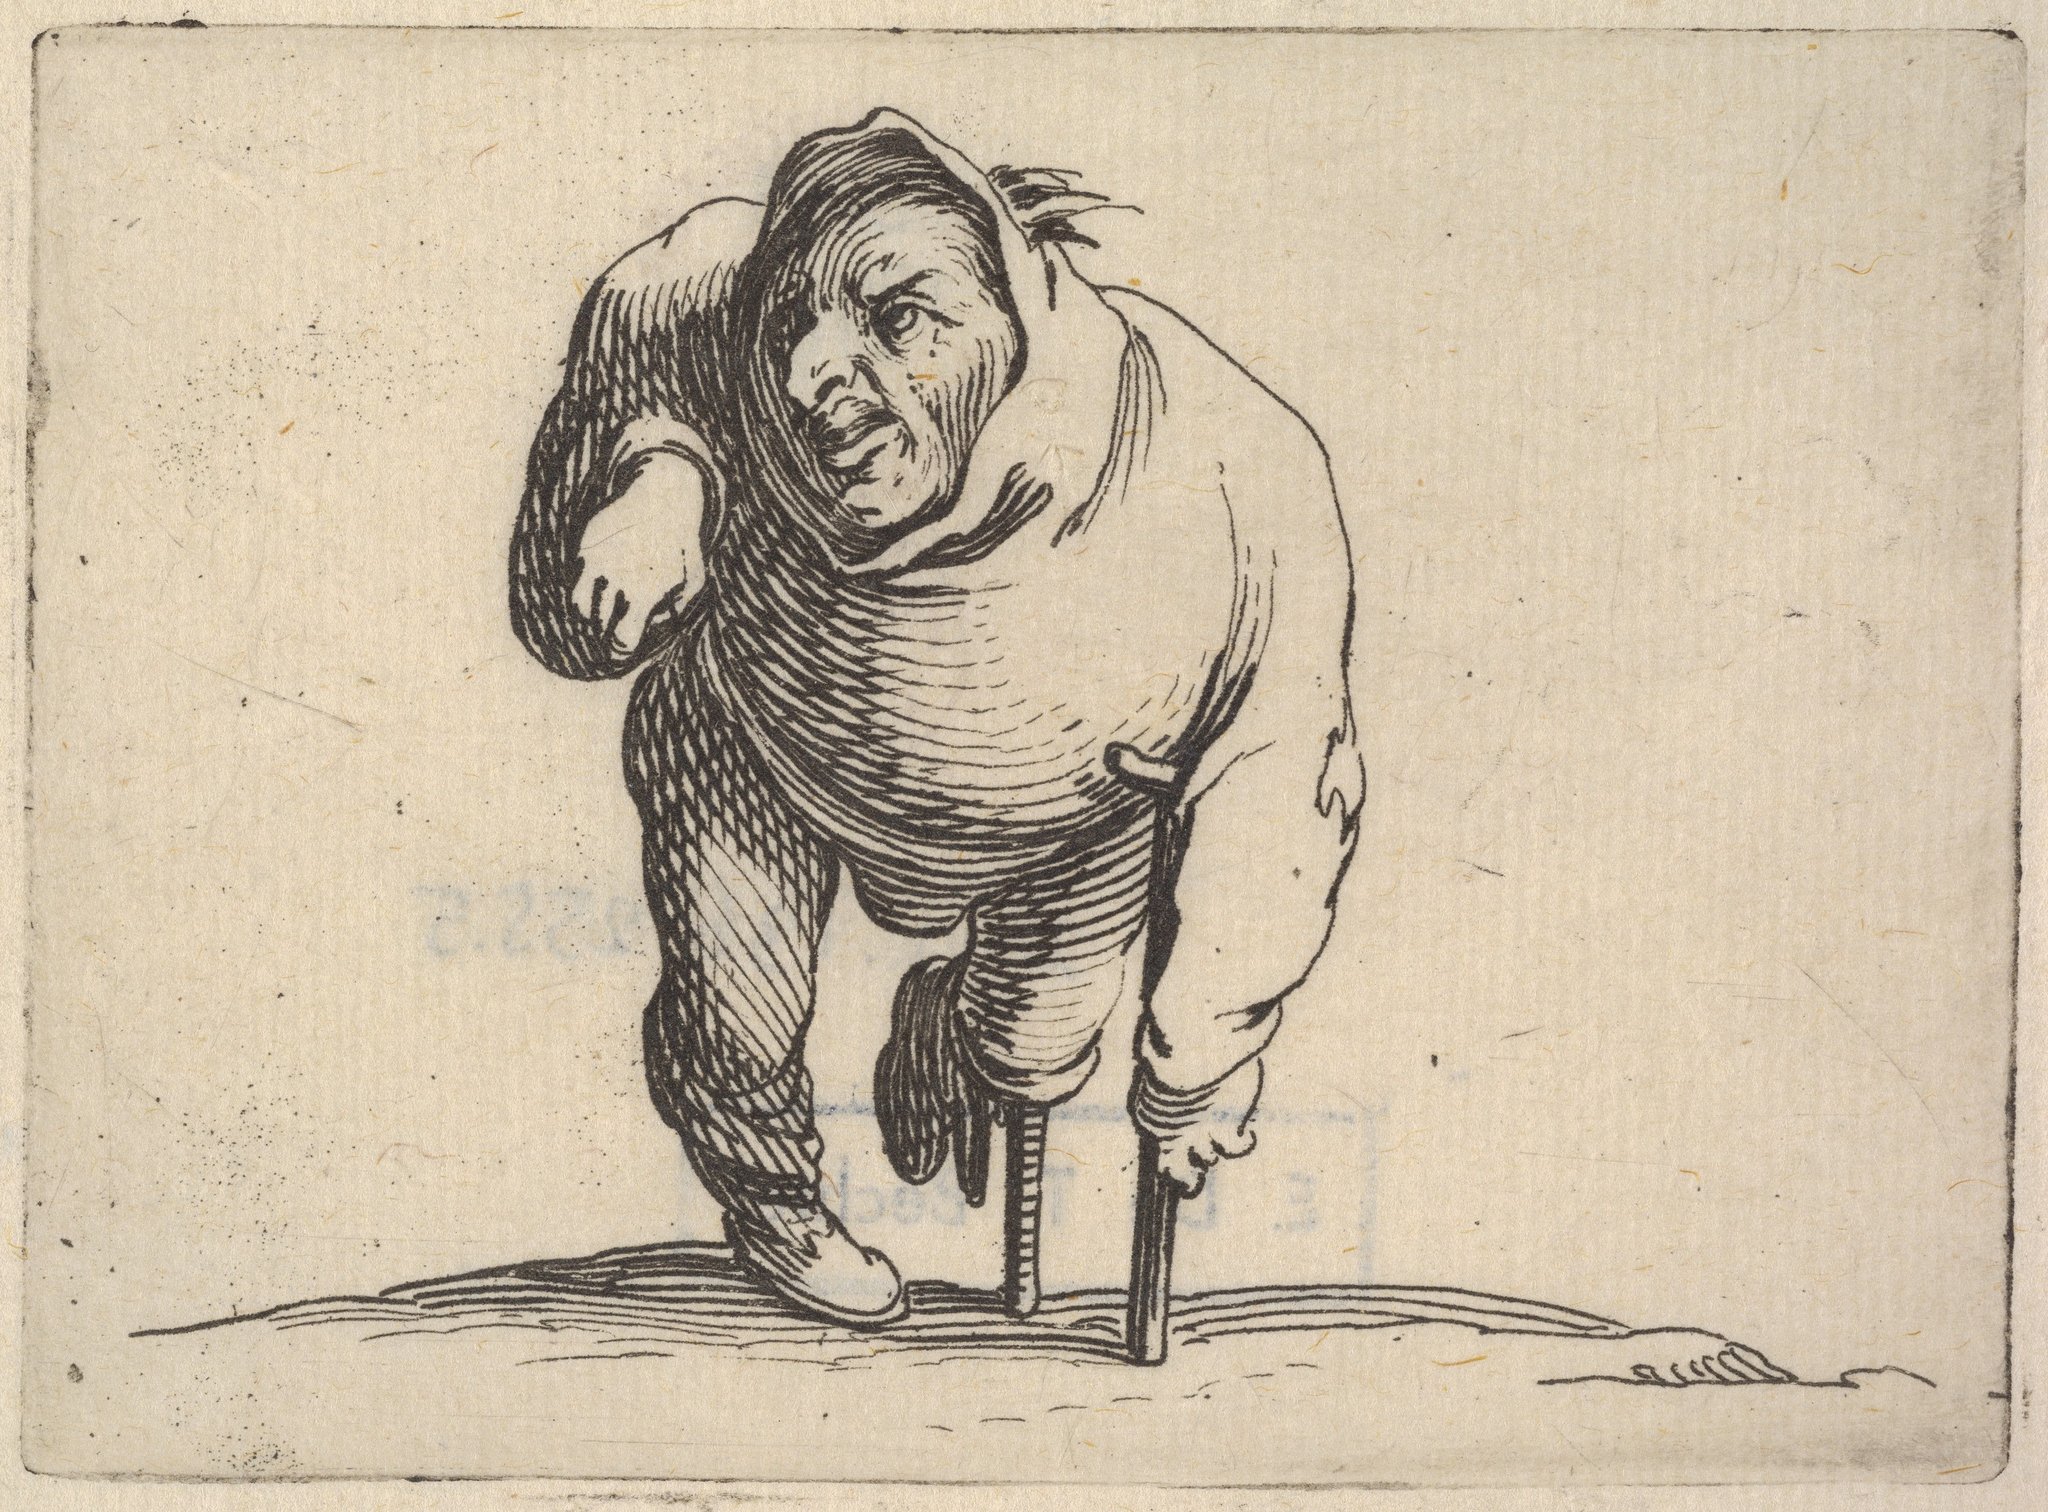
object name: print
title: Small male figure with peg leg and crutch, in frontal view, from "Varie Figure Gobbi"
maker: jacques callot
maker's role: artist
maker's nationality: french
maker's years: 1592-1635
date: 1621-1625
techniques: etching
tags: men